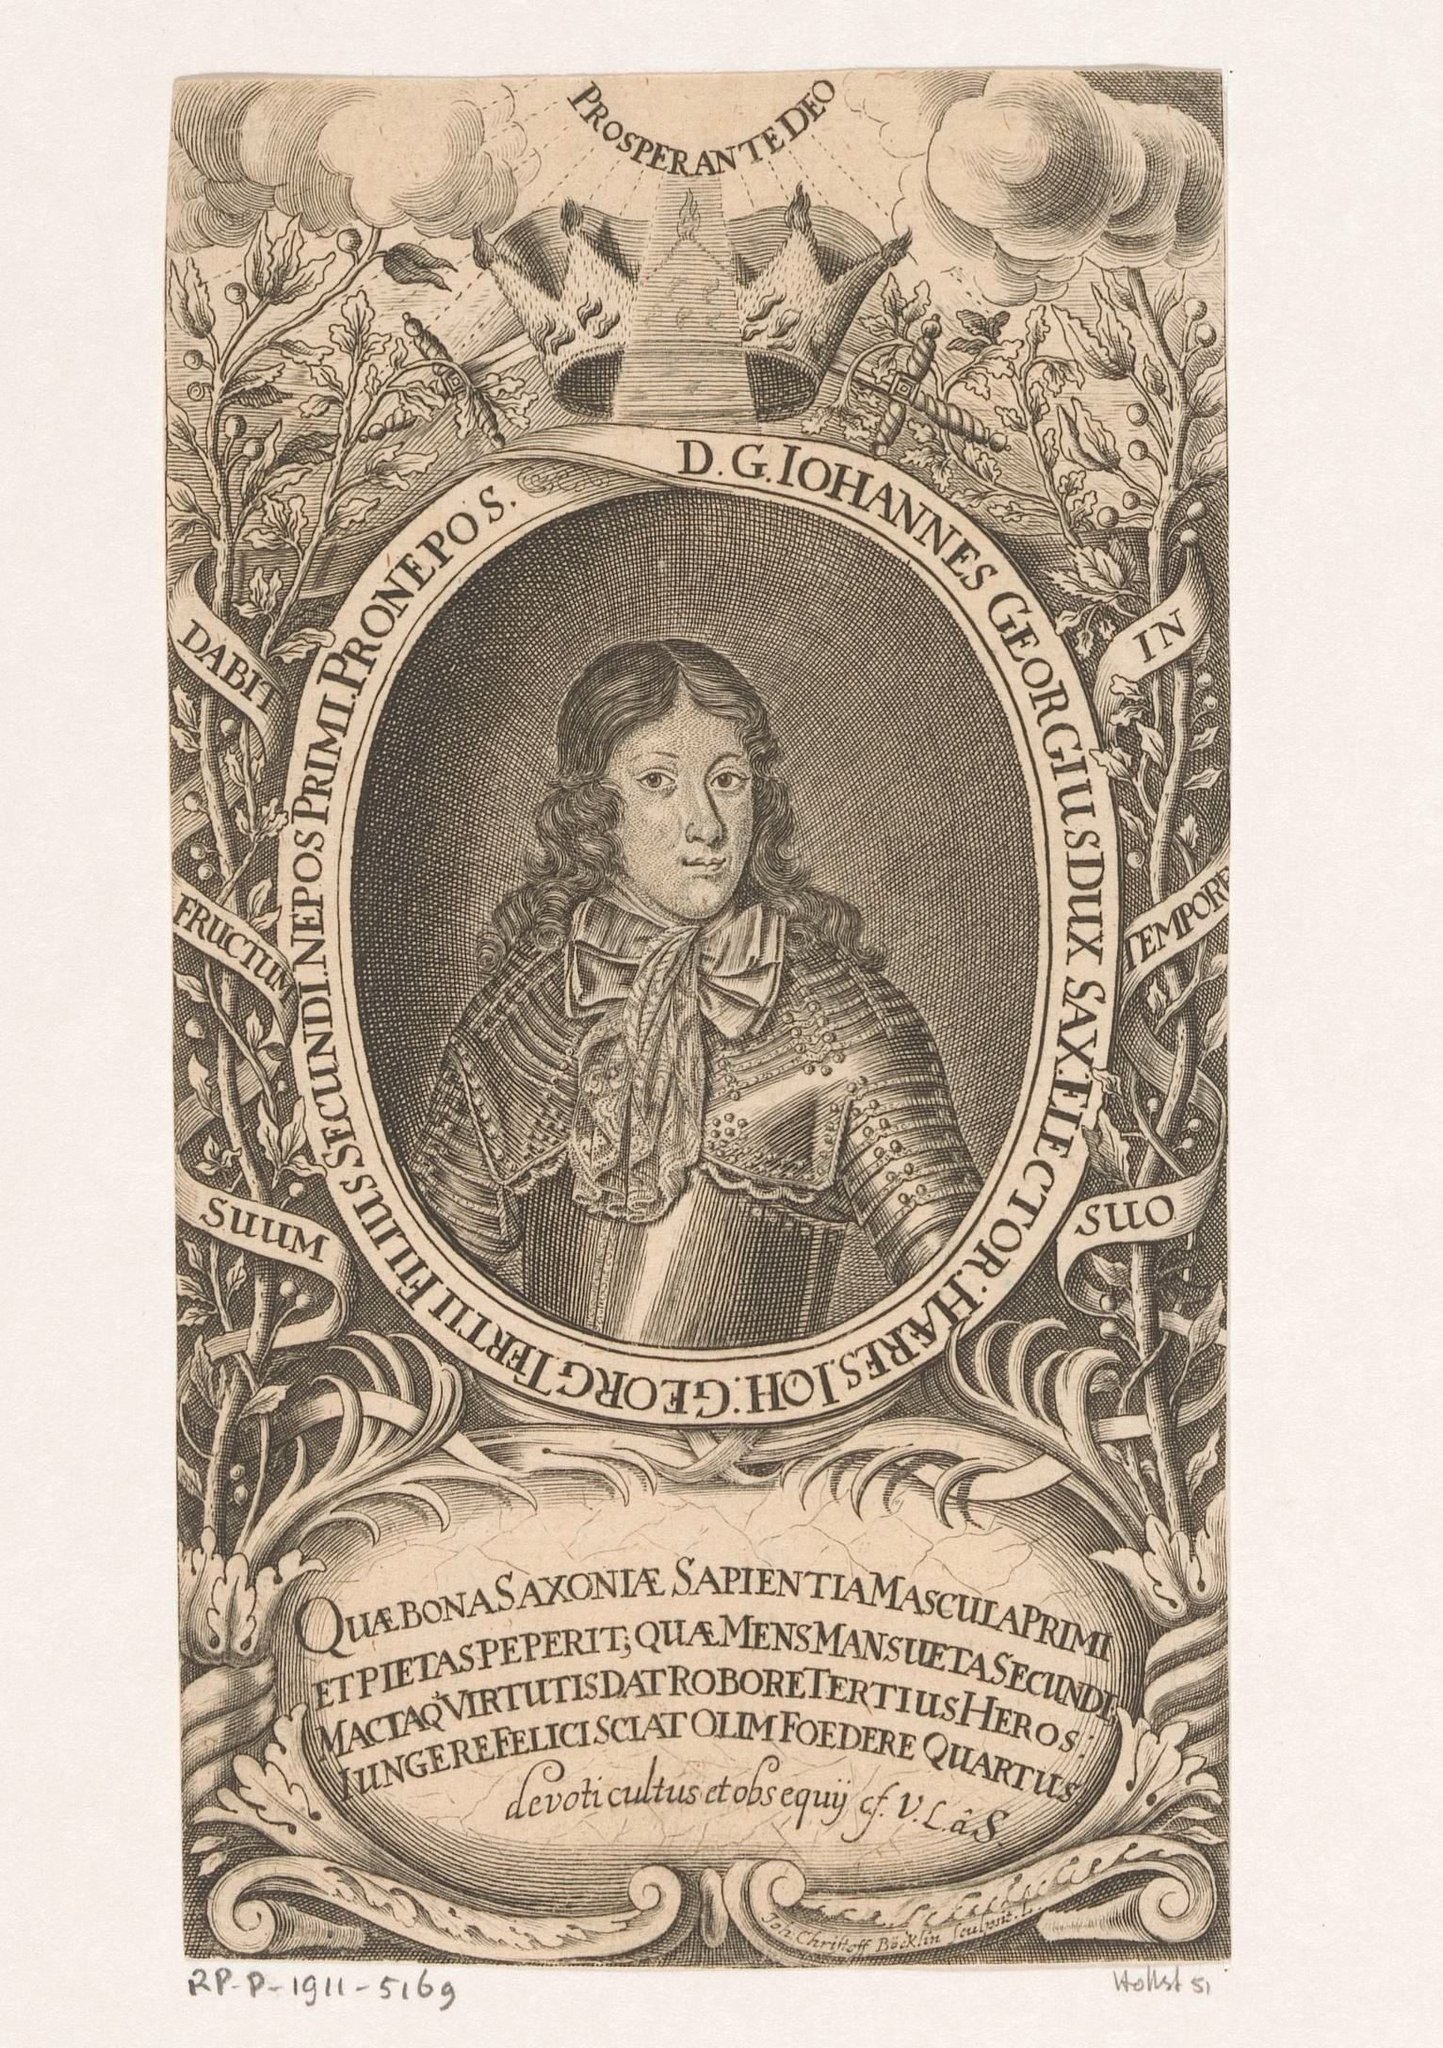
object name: print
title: Portret van Johann Georg IV von Sachsen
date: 1685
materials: paper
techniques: engraving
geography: leipzig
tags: crown (symbol of sovereignty), armour, historical persons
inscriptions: collector's mark: Lugt 2228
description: Prent ook gebruikt in: Seckenddorf, Veit Ludwig von. Christen-Stat In Drey Bücher abgetheilet (...). Leipzig: Johann Friedrich Gleditsch, 1685.